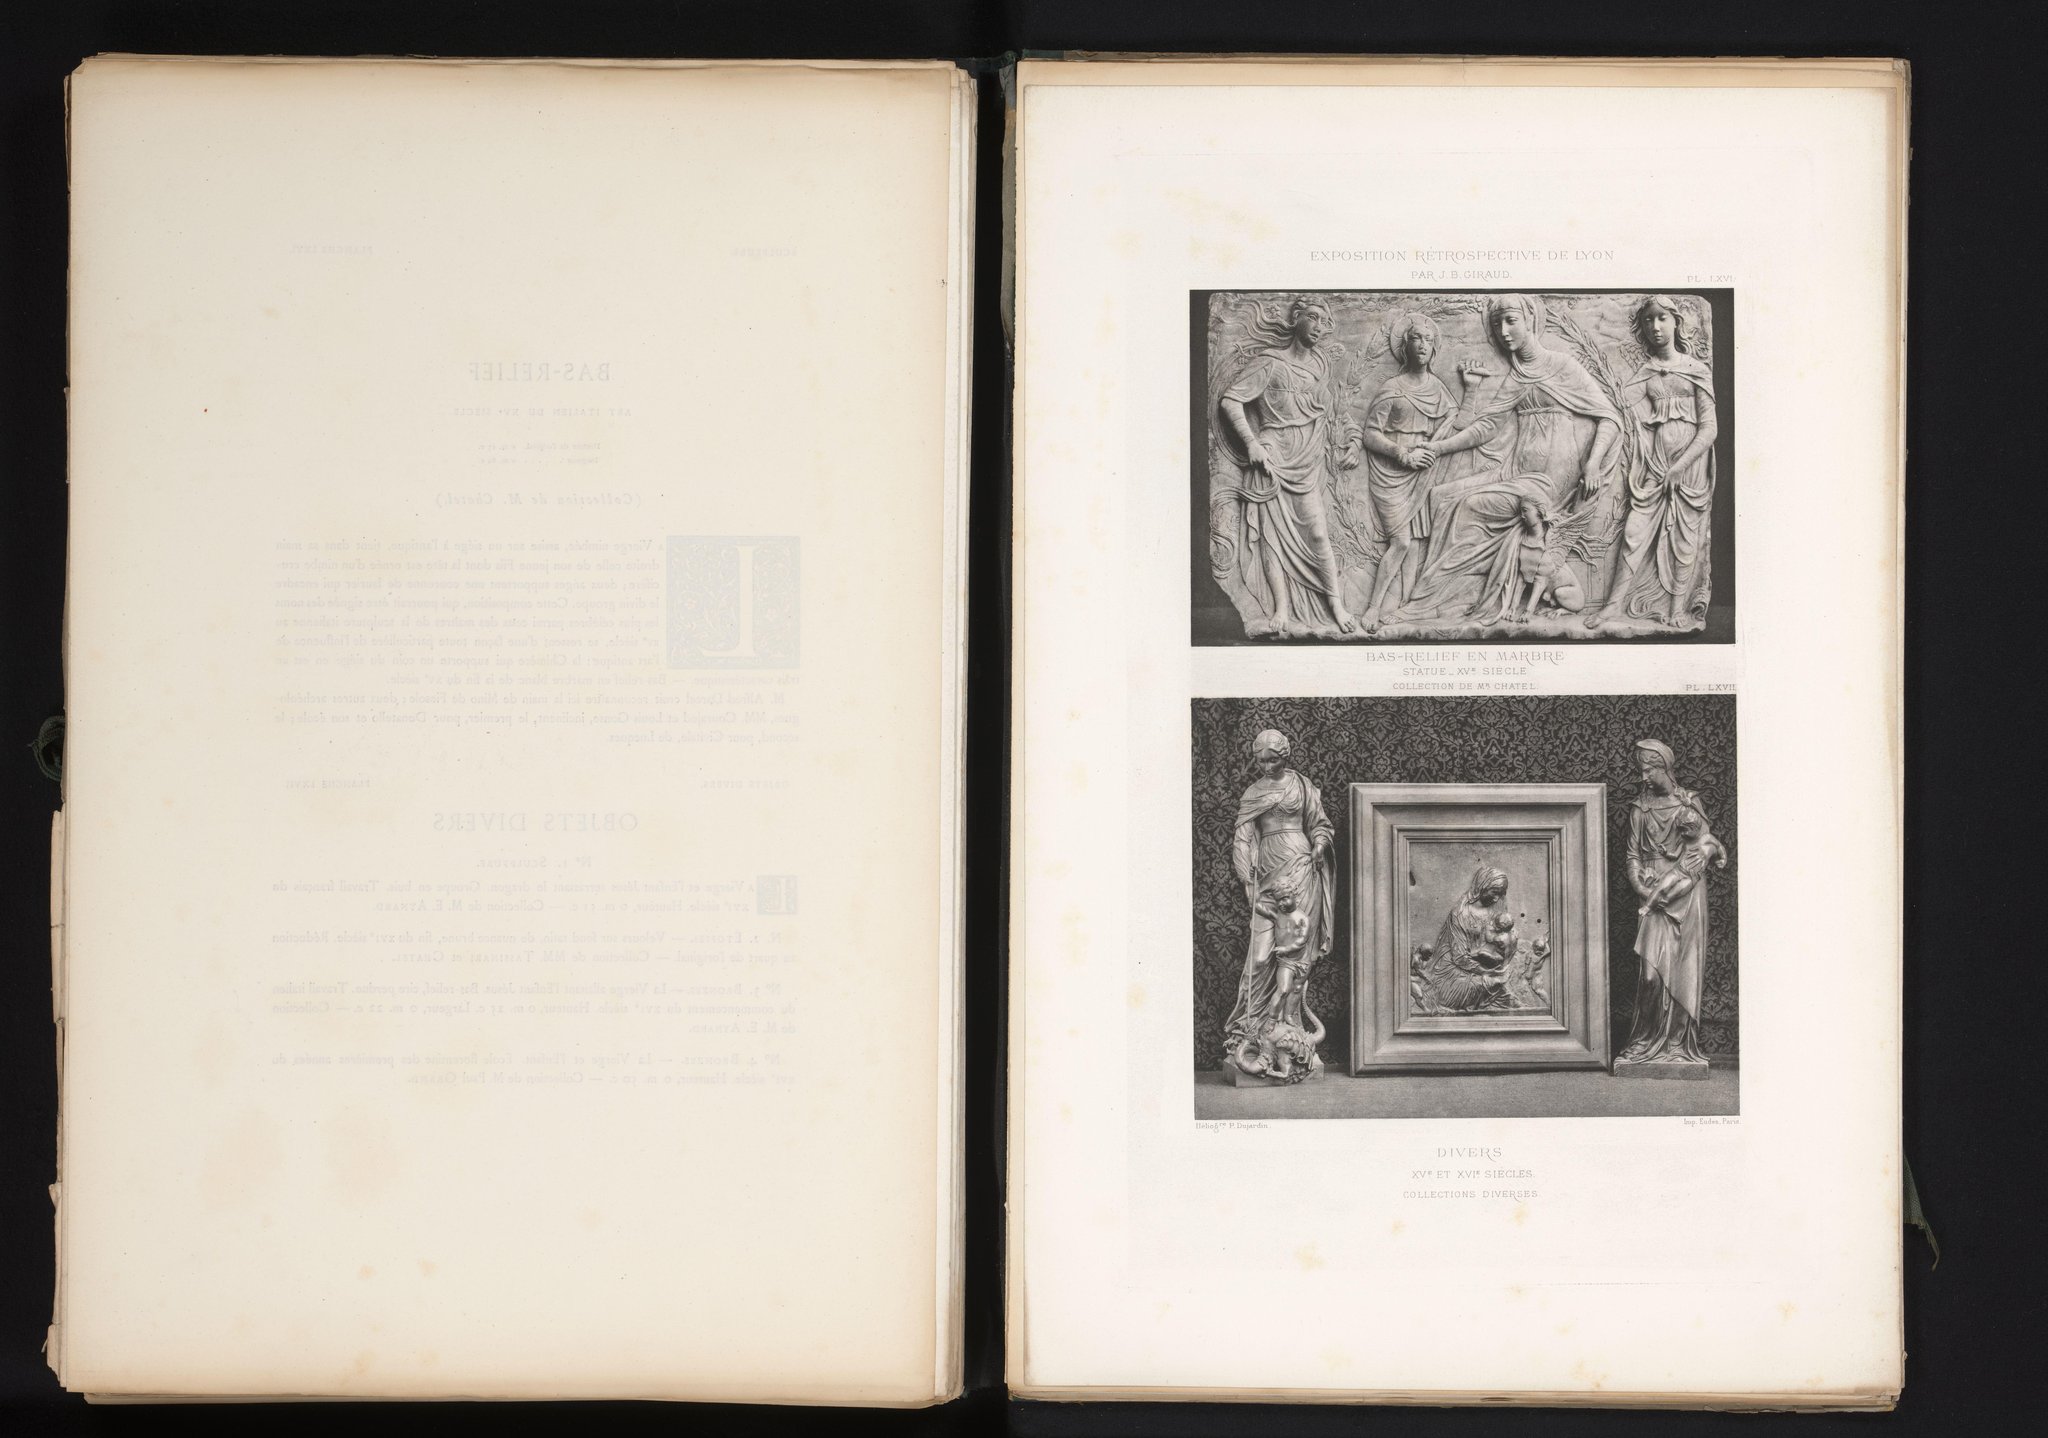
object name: photomechanical print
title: Twee 15de-eeuwse en 16de-eeuwse reliëfs en twee sculpturen, op de Exposition Rétrospective van 1877 in Lyon, Frankrijk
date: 1877-1878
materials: paper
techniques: photoaquatint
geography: lyon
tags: piece of sculpture, reproduction of a piece of sculpture, lyon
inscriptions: number: ‘PL. LXVI.’, inscription: ‘EXPOSITION RÉTROSPECTIVE DE LYON/ PAR J. B. GIRAUD.’, inscription: ‘DIVERS/ XVe ET XVIe SIÈCLES./ COLLECTIONS DIVERSES.’, inscription: ‘BAS-RELIEF EN MARBRE/ STATUE_XVe SIÈCLE/ COLLECTION DE Mr CHATEL.’, number: ‘PL. LXVII.’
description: Deze prenten maken deel uit van een omslag met 79 prenten op 54 bladen en 65 tekstbladen.